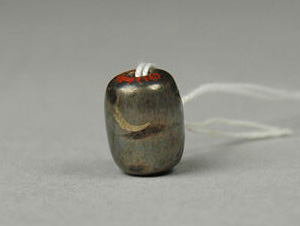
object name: ojime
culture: japanese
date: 1801-1900